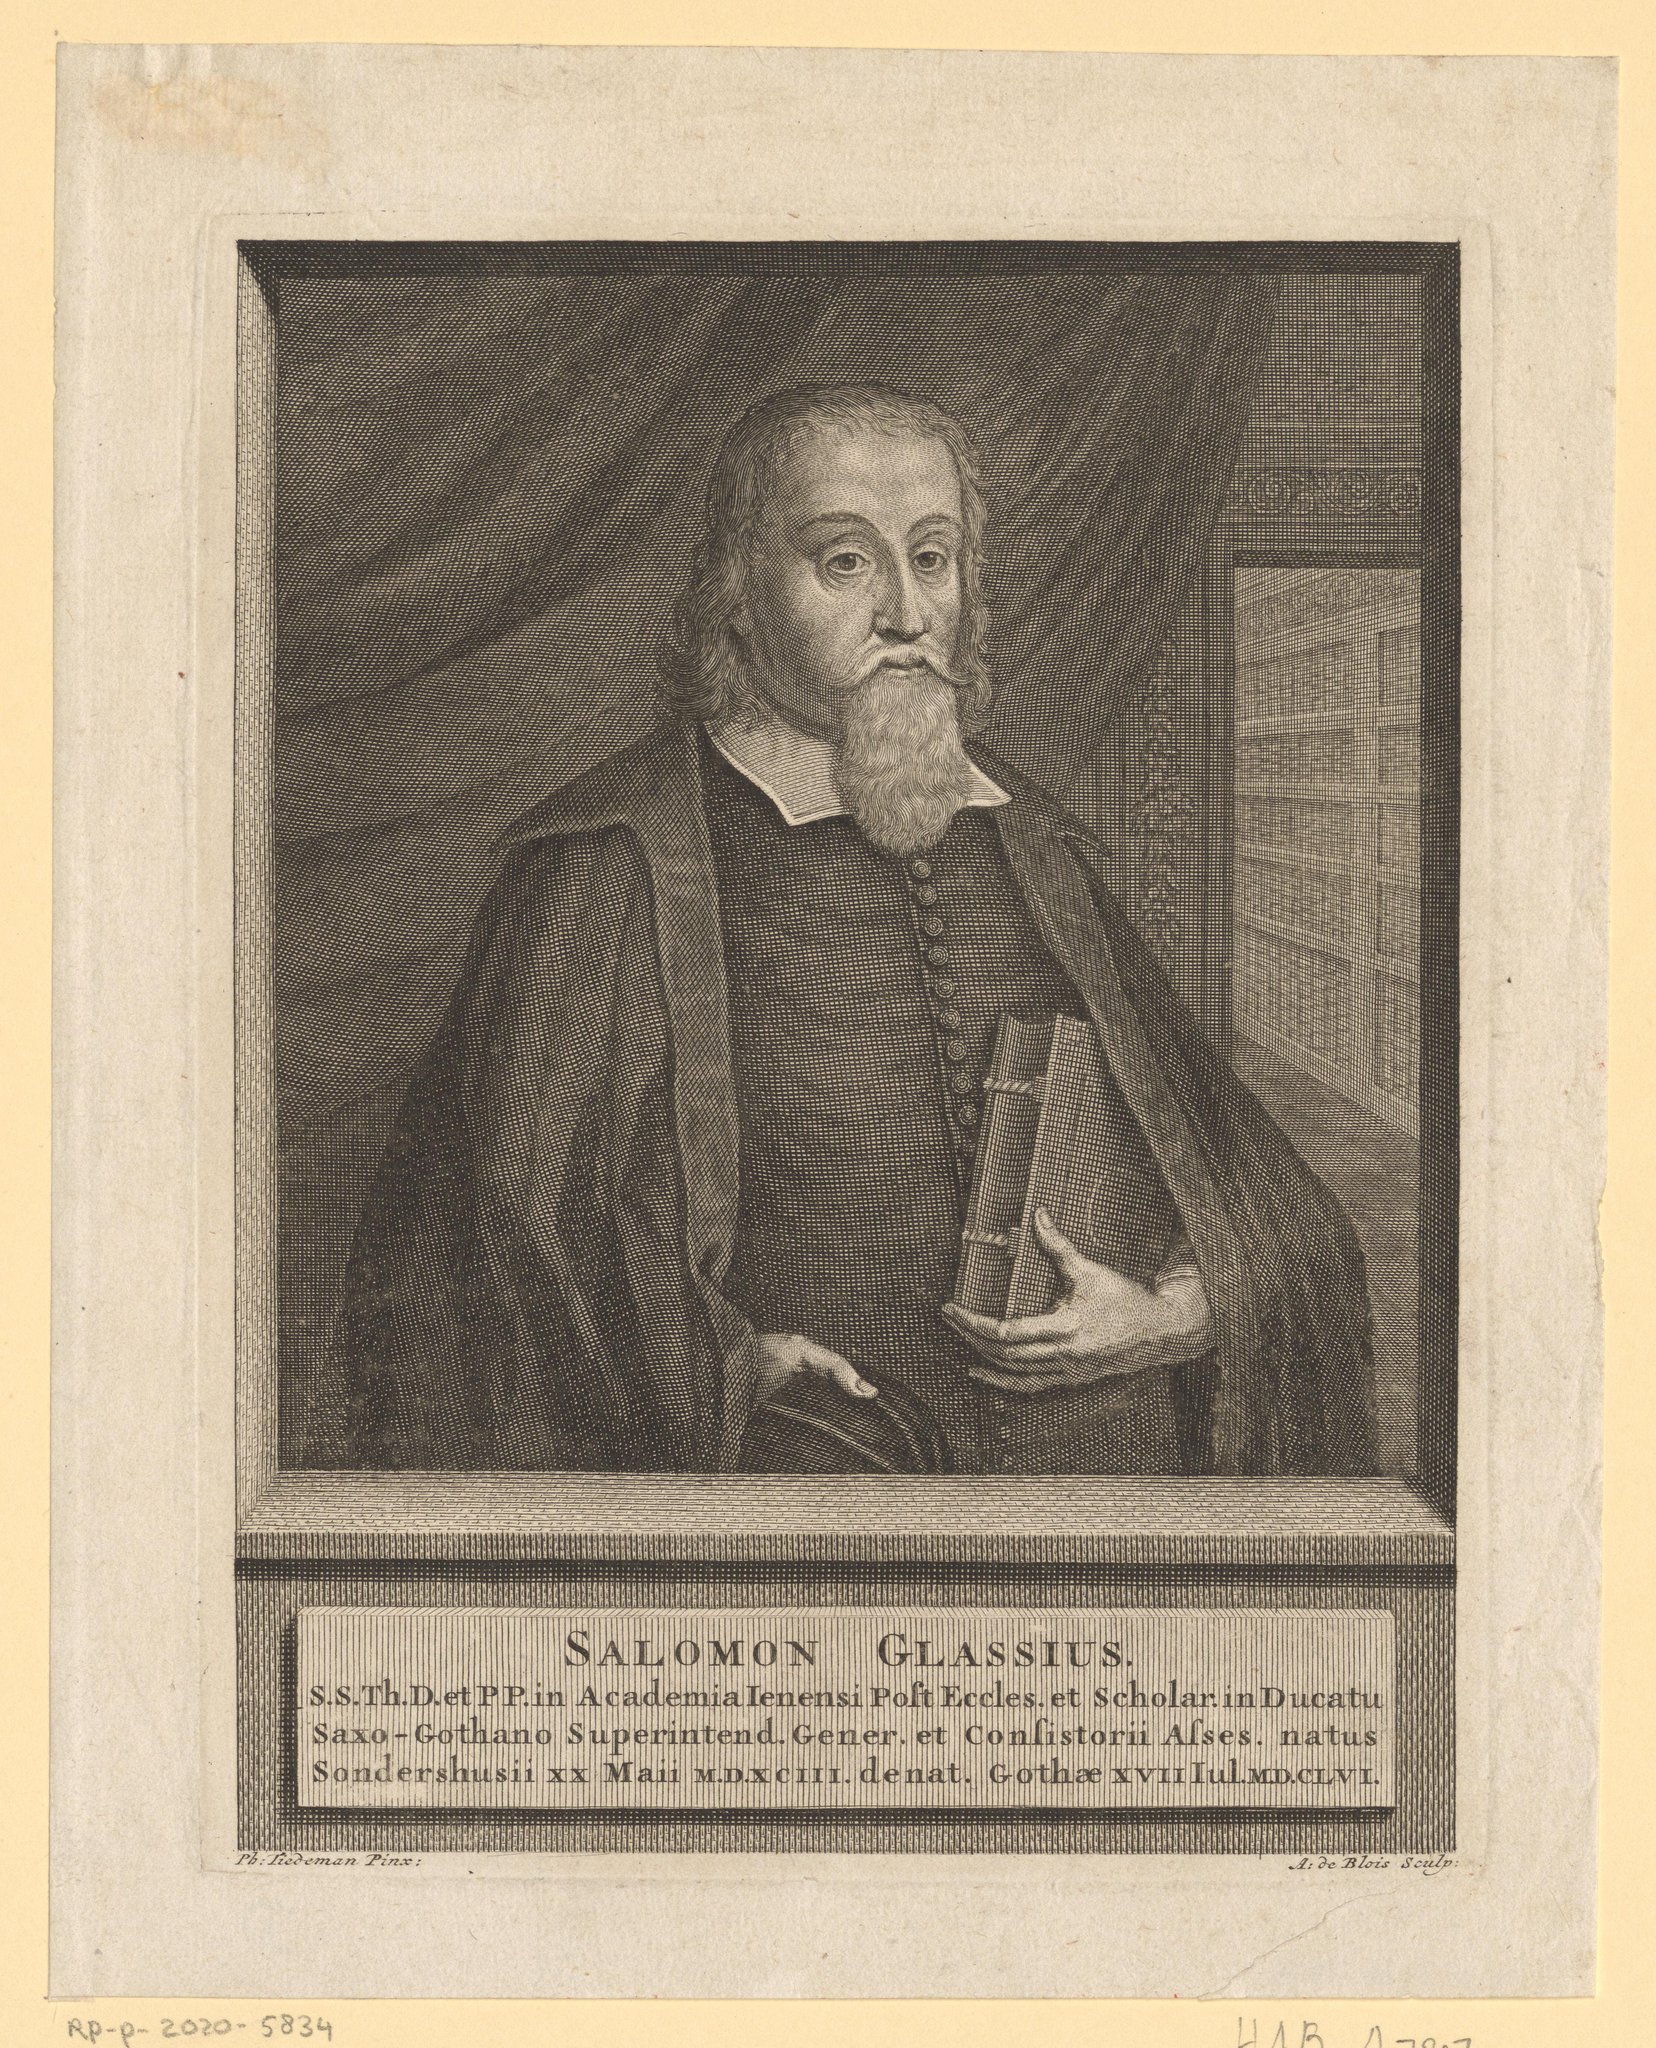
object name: print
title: Portret van Salomon Glass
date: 1656-1717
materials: paper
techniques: engraving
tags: theologian, historical persons